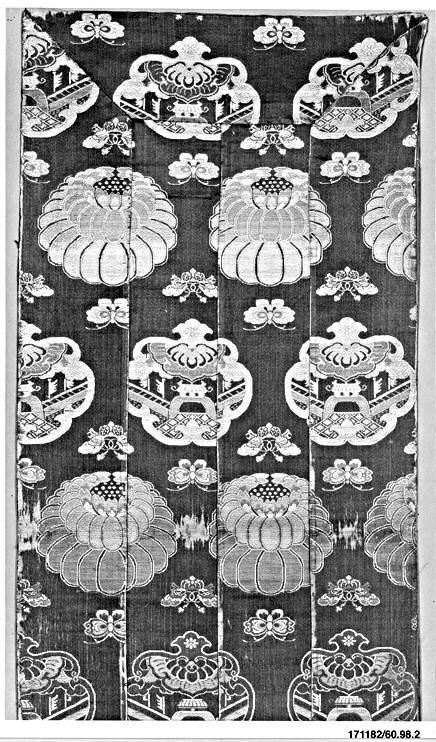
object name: stole, priest's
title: Priest's Stole (O-Hi)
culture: japanese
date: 1601-1700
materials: metal thread, silk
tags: butterflies